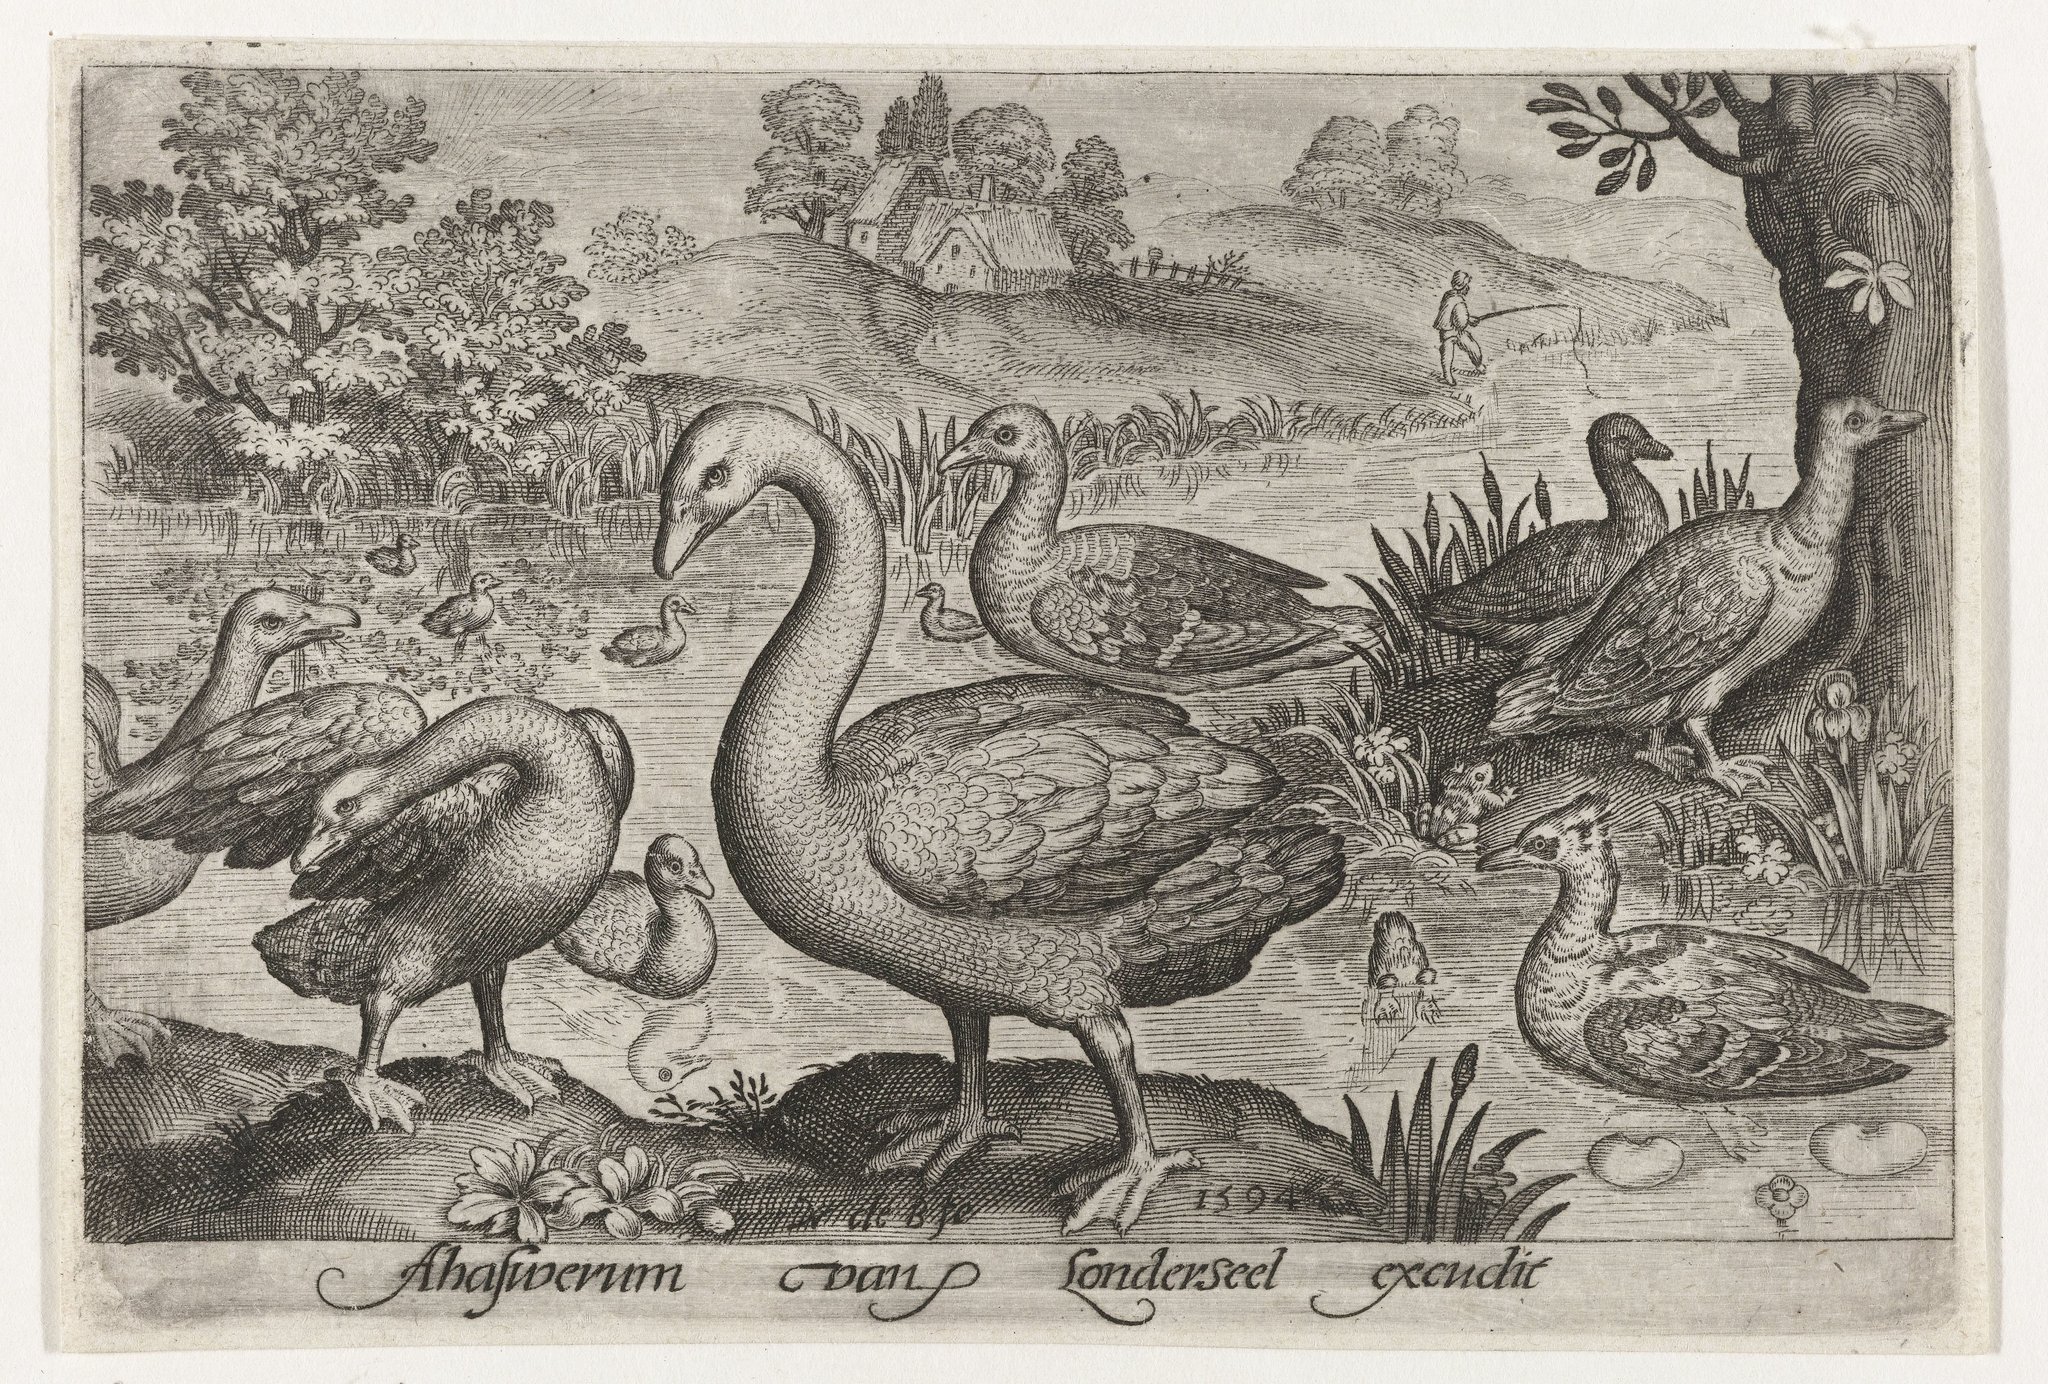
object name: print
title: Zwaan en ganzen en eenden bij water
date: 1594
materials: paper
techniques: engraving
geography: antwerp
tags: water-birds: goose, water-birds: swan, water-birds: duck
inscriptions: collector's mark: Lugt 2228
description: Prent uit serie van twaalf prenten met vogels en insecten. Bij Hollstein zijn bladen van een andere serie prenten afgebeeld, zie De Groot 1988, p. 37.